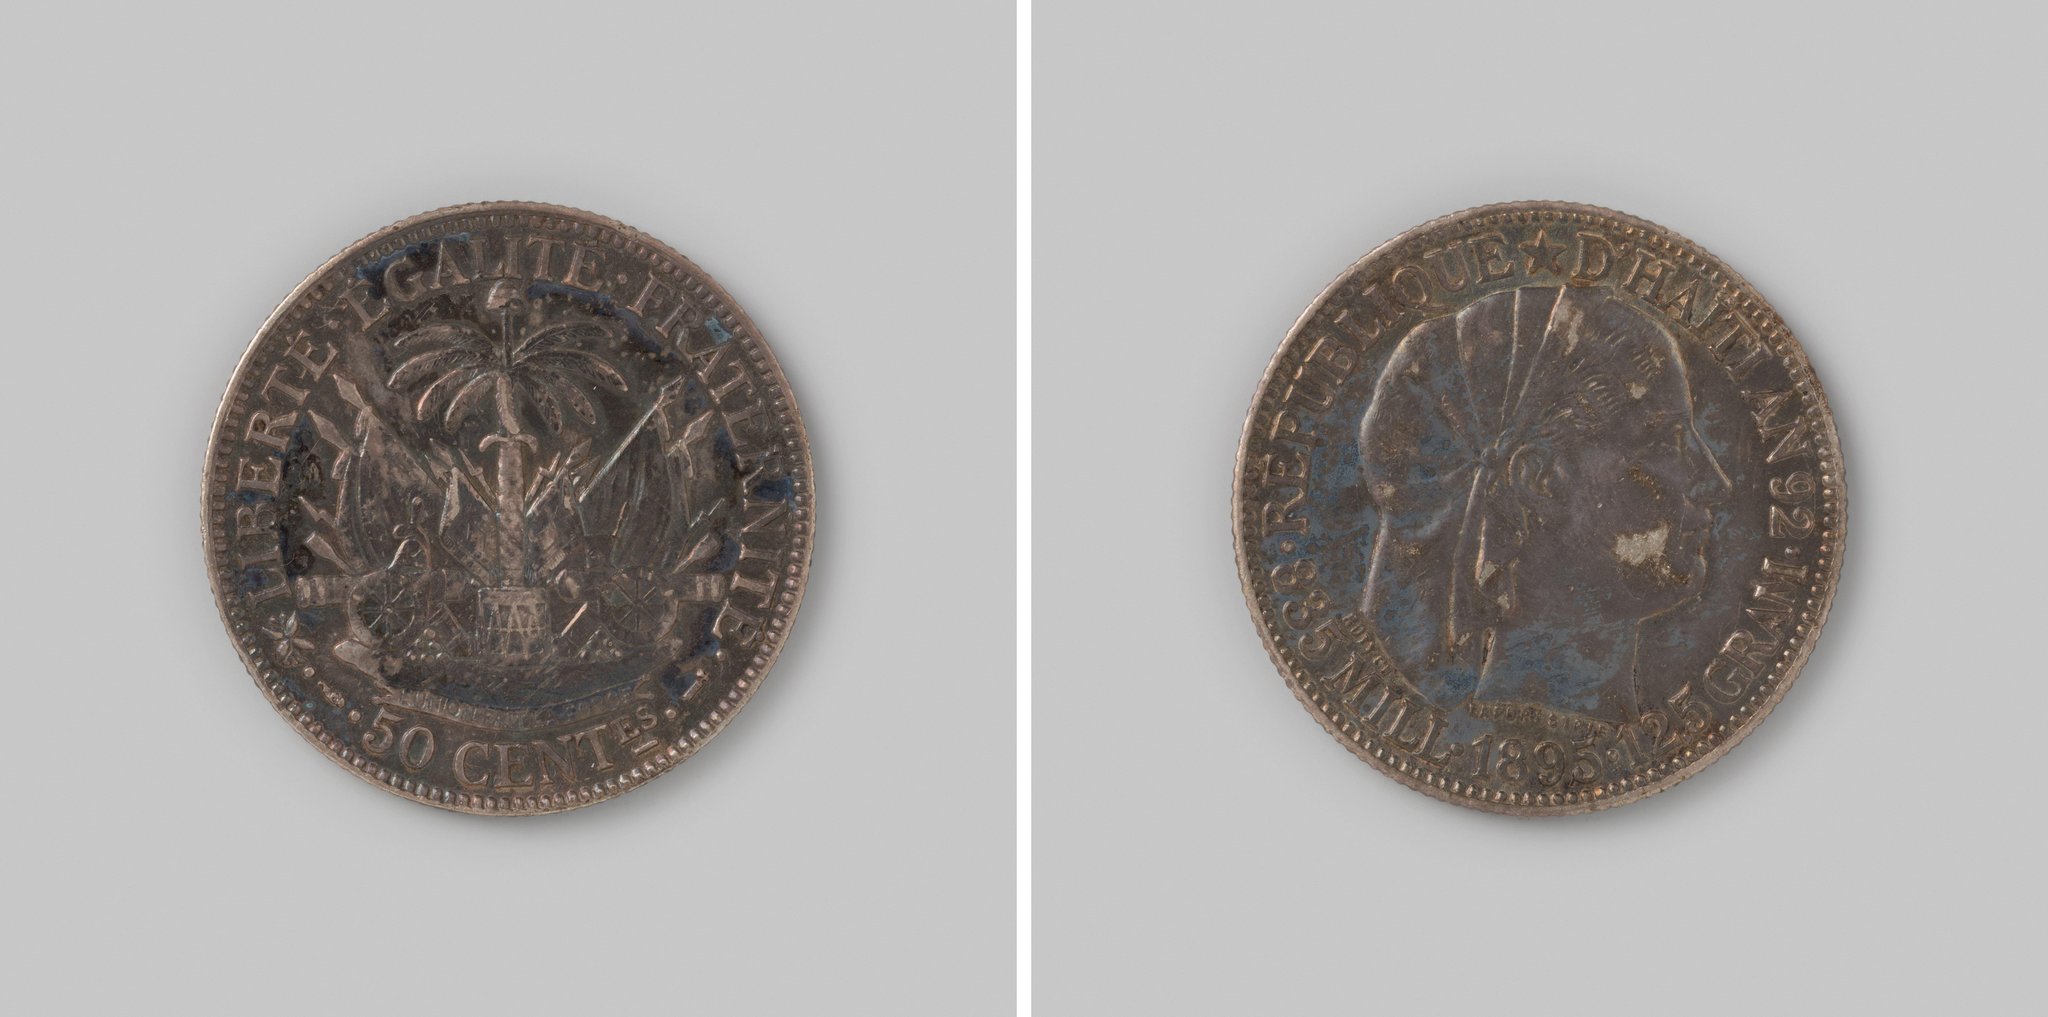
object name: coin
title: Haïti, 50 centimes of ½ gourde, 1895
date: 1895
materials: silver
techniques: striking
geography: paris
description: Zilveren munt. Voorzijde: uit trommel oprijzende palmboom, waarachter banieren. links en rechts van trommel twee kanonnen, waaronder stapel kogels. Daaronder banderol met spreuk. Onderaan waarde-aanduiding: 50 centimes. Keerzijde: hoofd van een vrouw met hoofddoek naar rechts. In omschrift onderaan jaartal: 1895 en gehalte- en gewichtsaanduiding en jaartal: AN 92. Kartelrand.